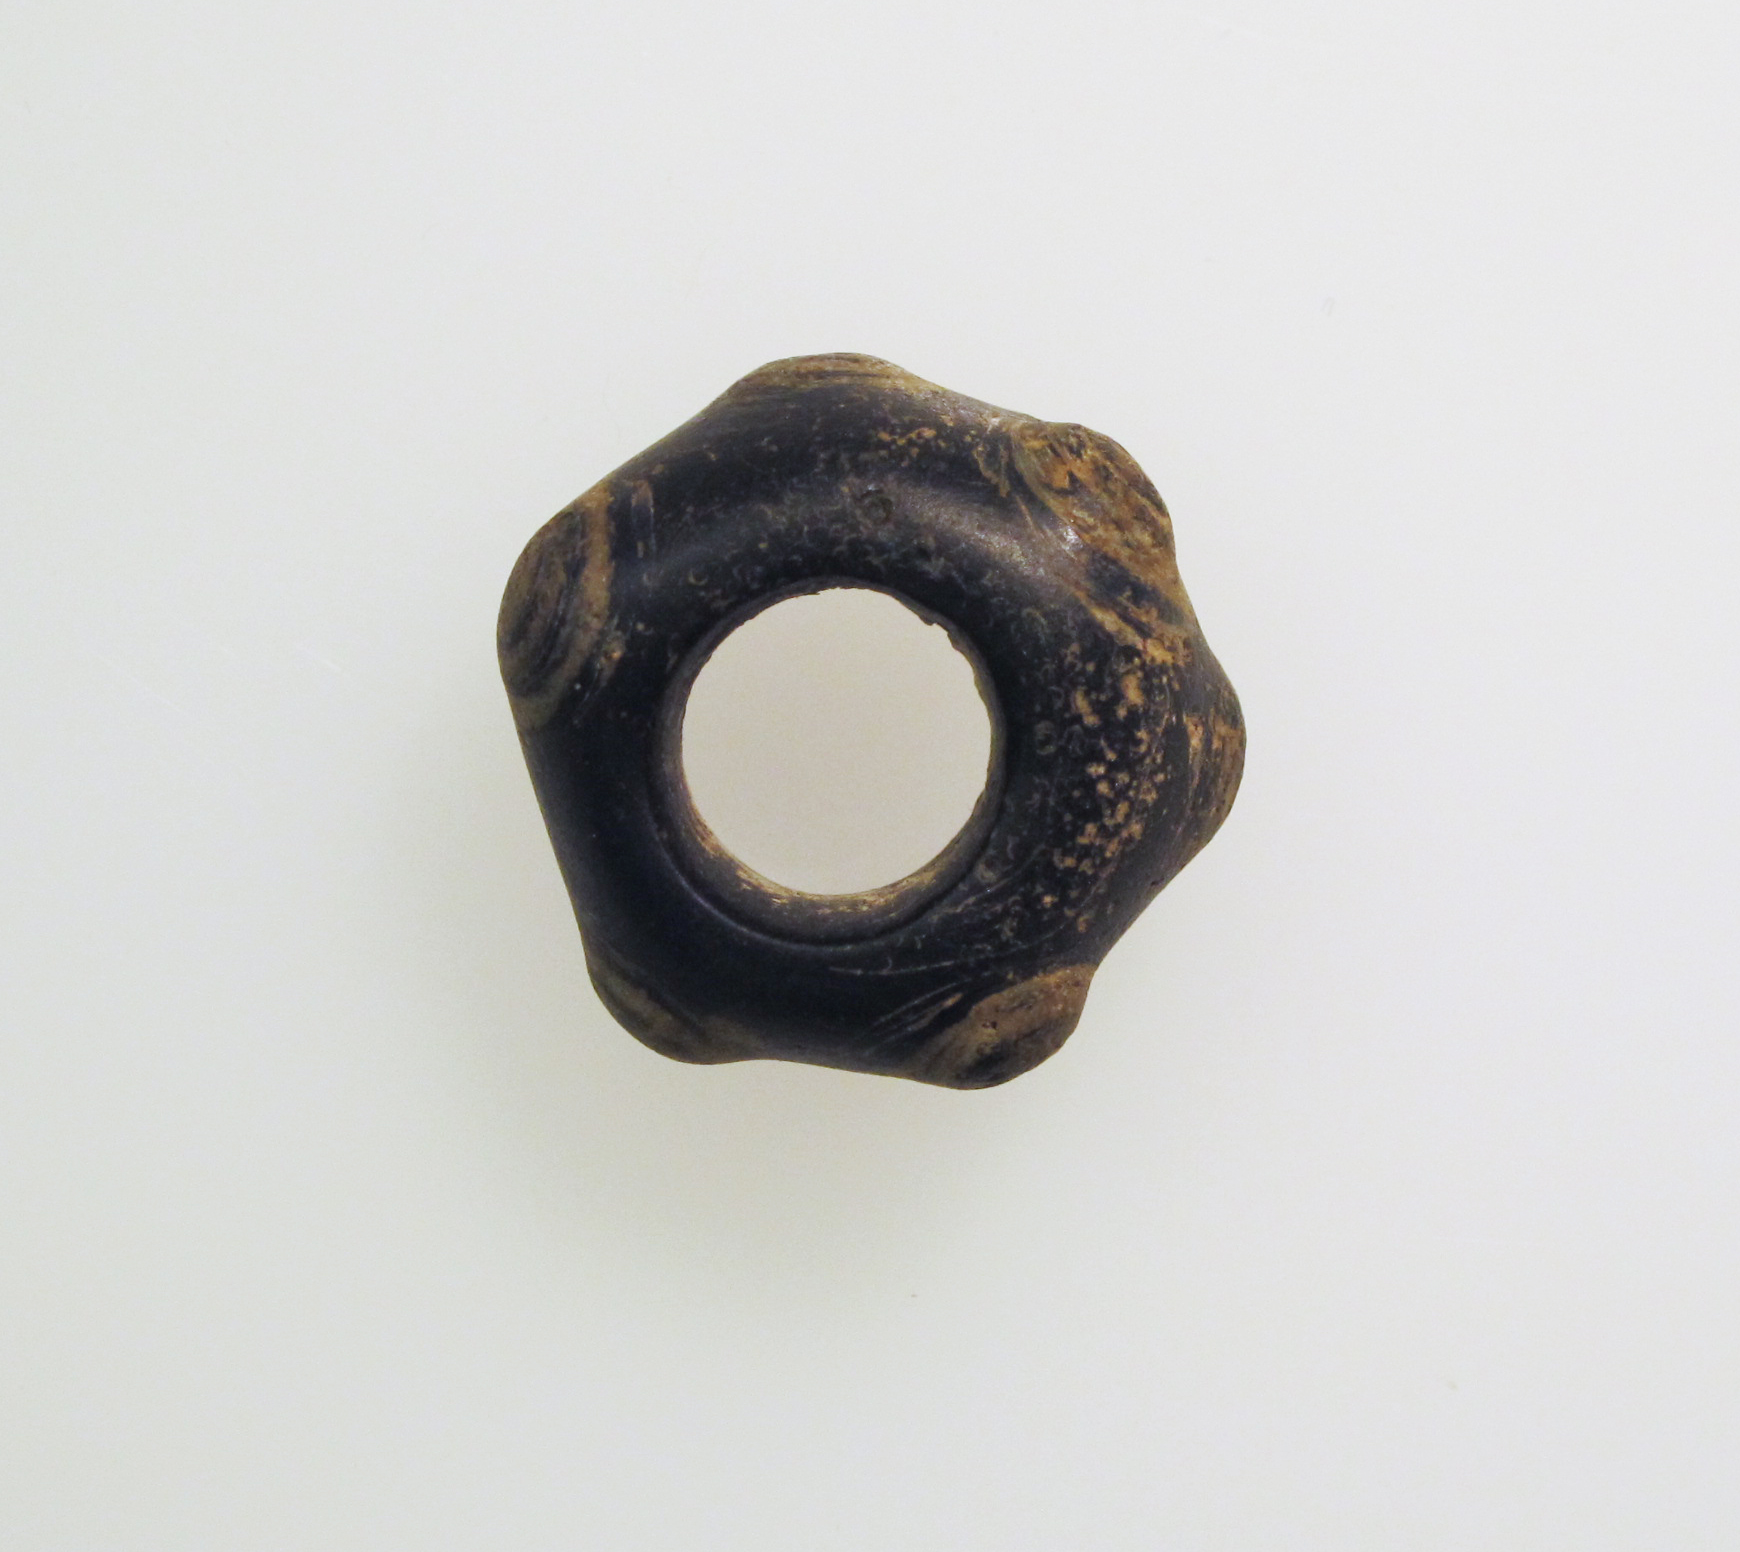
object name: bead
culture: roman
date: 100 BCE-500 CE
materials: glass